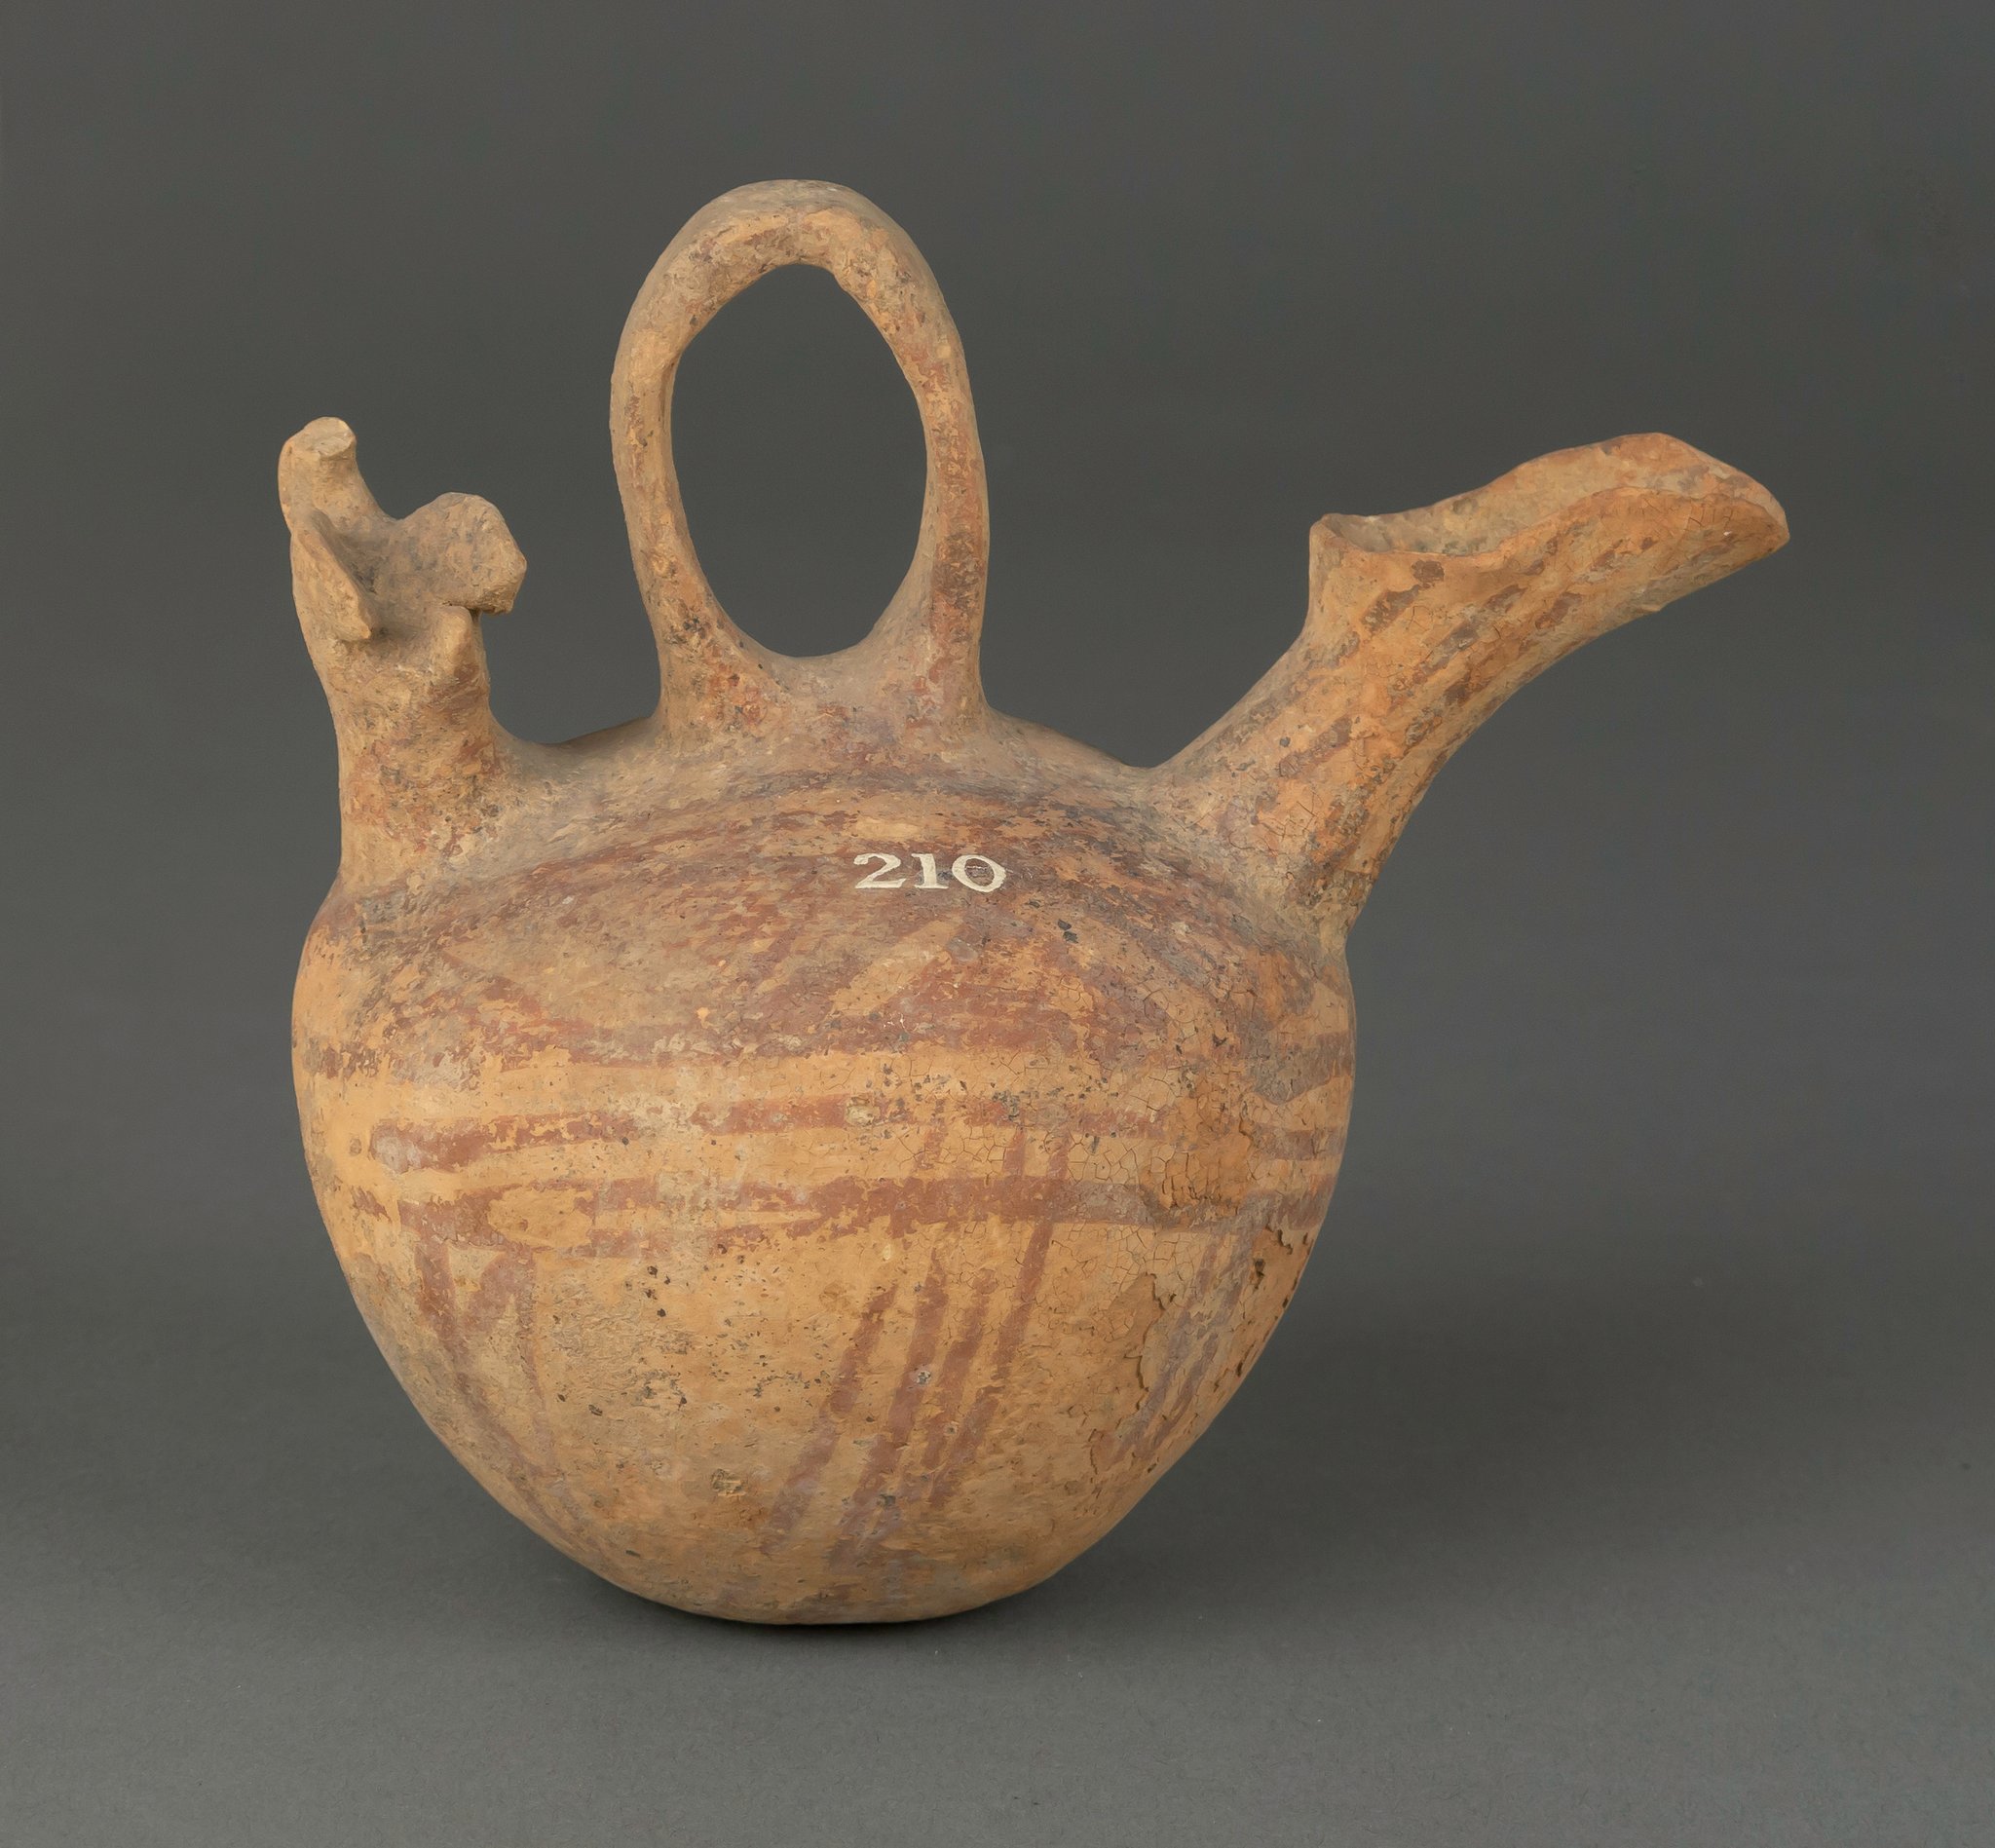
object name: askos in the form of an animal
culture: cypriot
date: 1900-1600 BCE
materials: terracotta